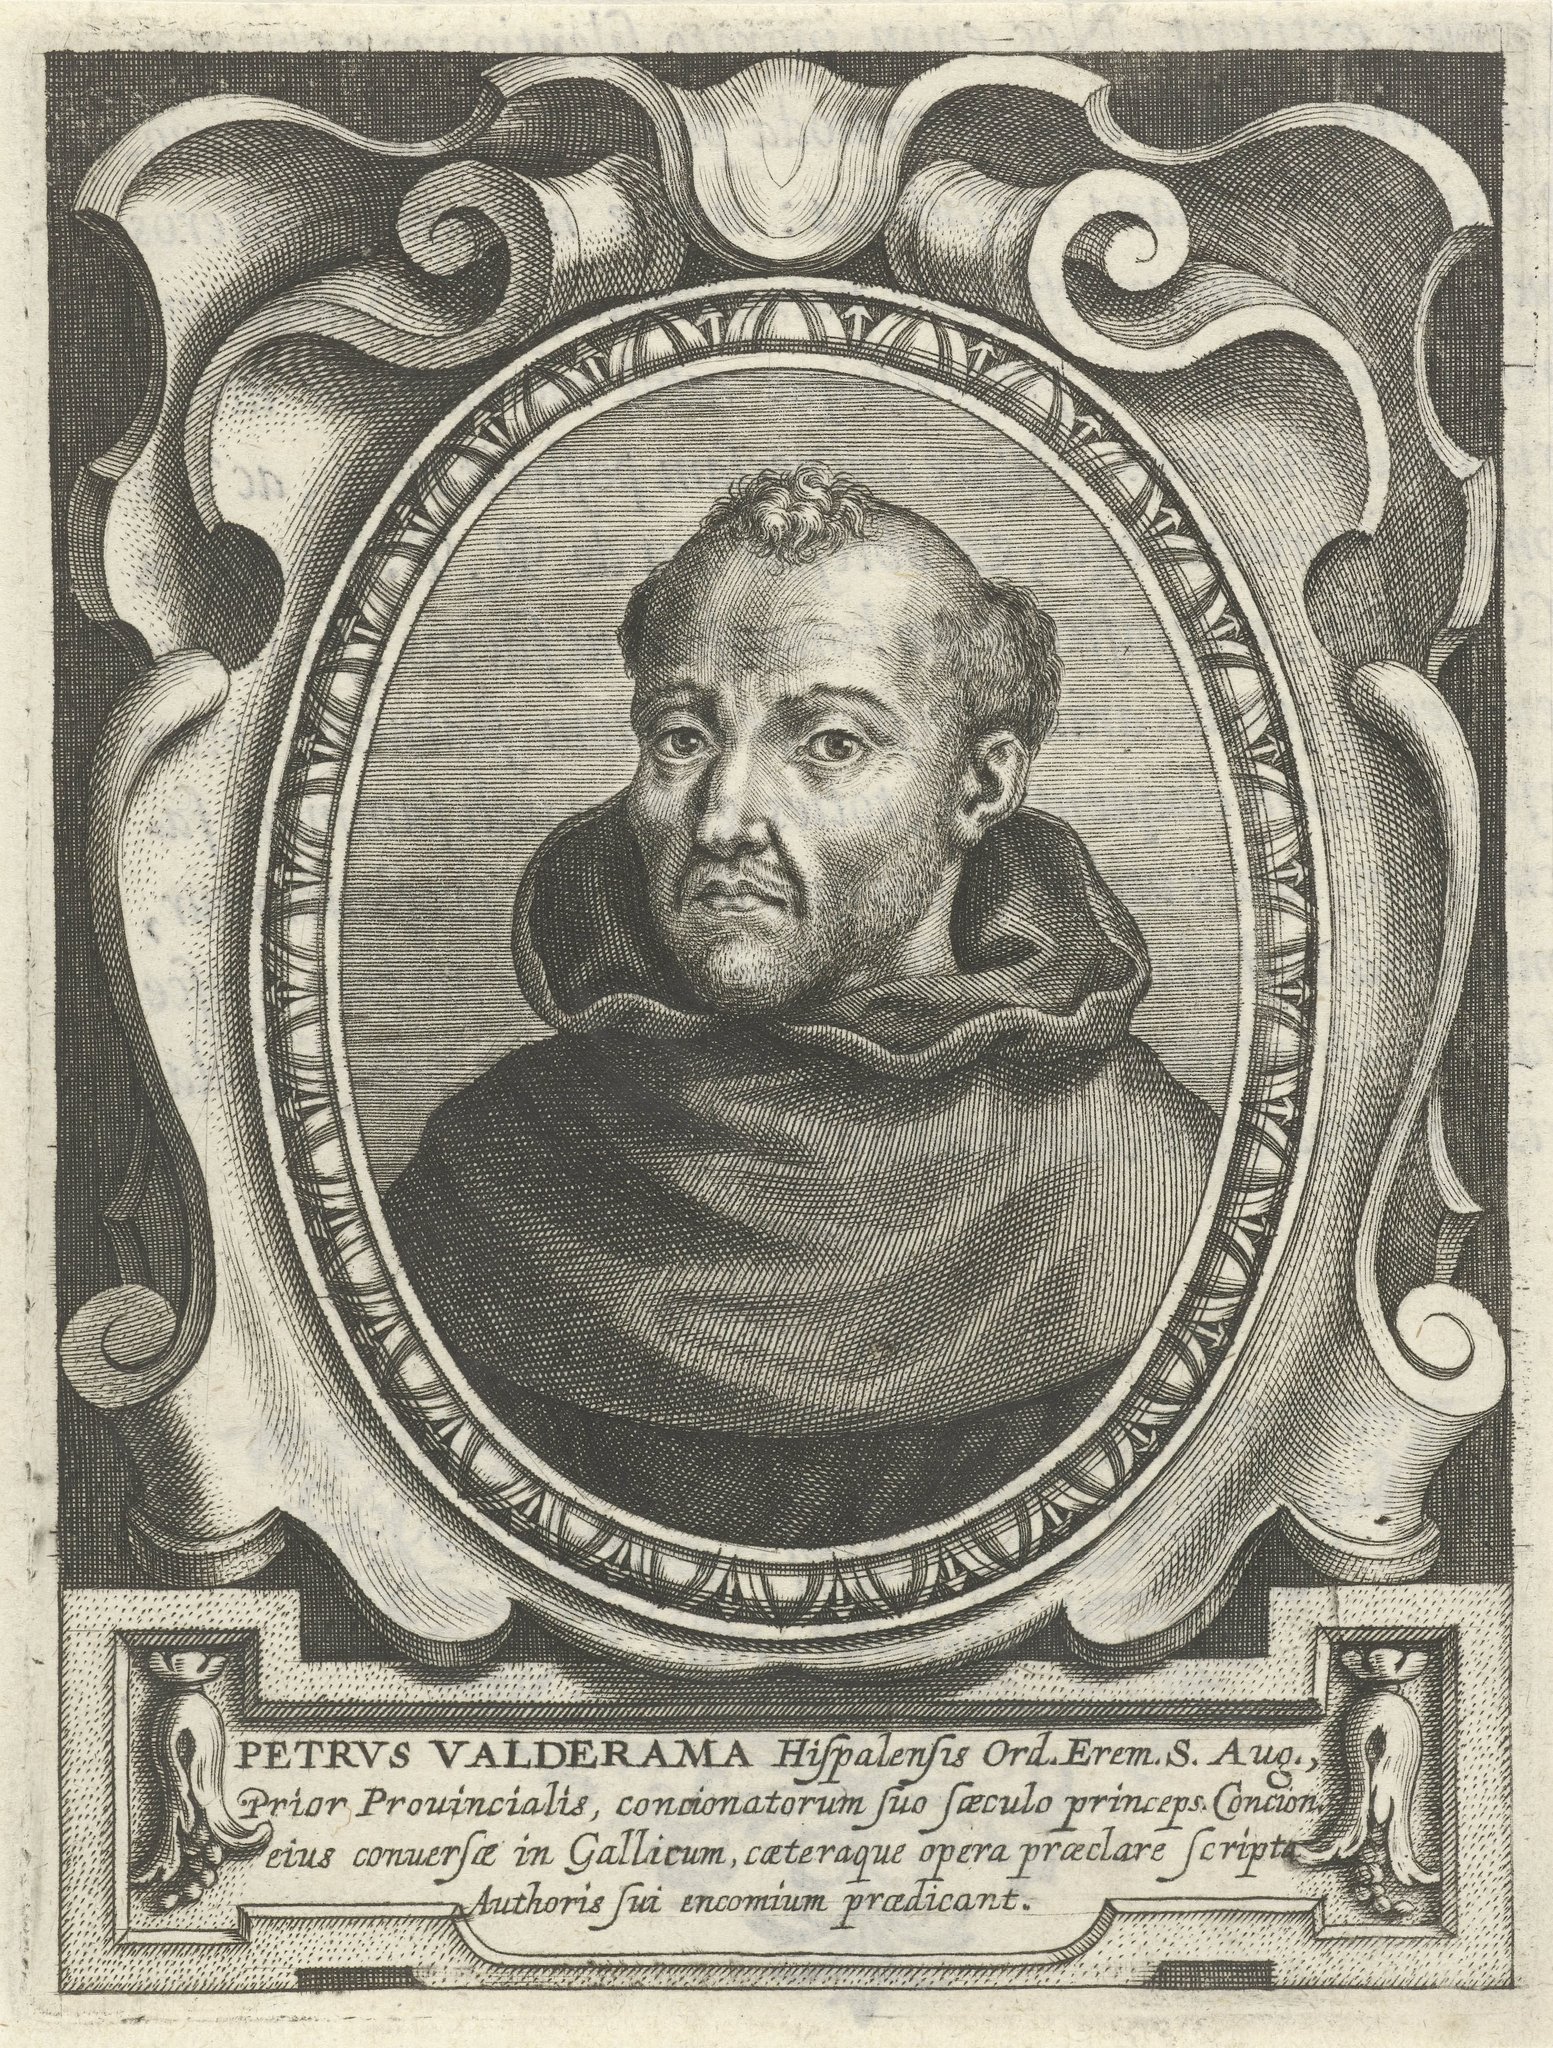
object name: book illustration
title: Portret van de Augustijn Petrus Valderama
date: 1636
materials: paper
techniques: engraving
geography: southern netherlands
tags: monastic orders, monastic life ~ roman catholic church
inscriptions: collector's mark: Lugt 2228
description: Boekillustratie voor: C. Curtius, Virorum illustrium ex ordine Eremitarum D. Augustini elogia , Antwerpen: J. Cnobbaert, 1636.